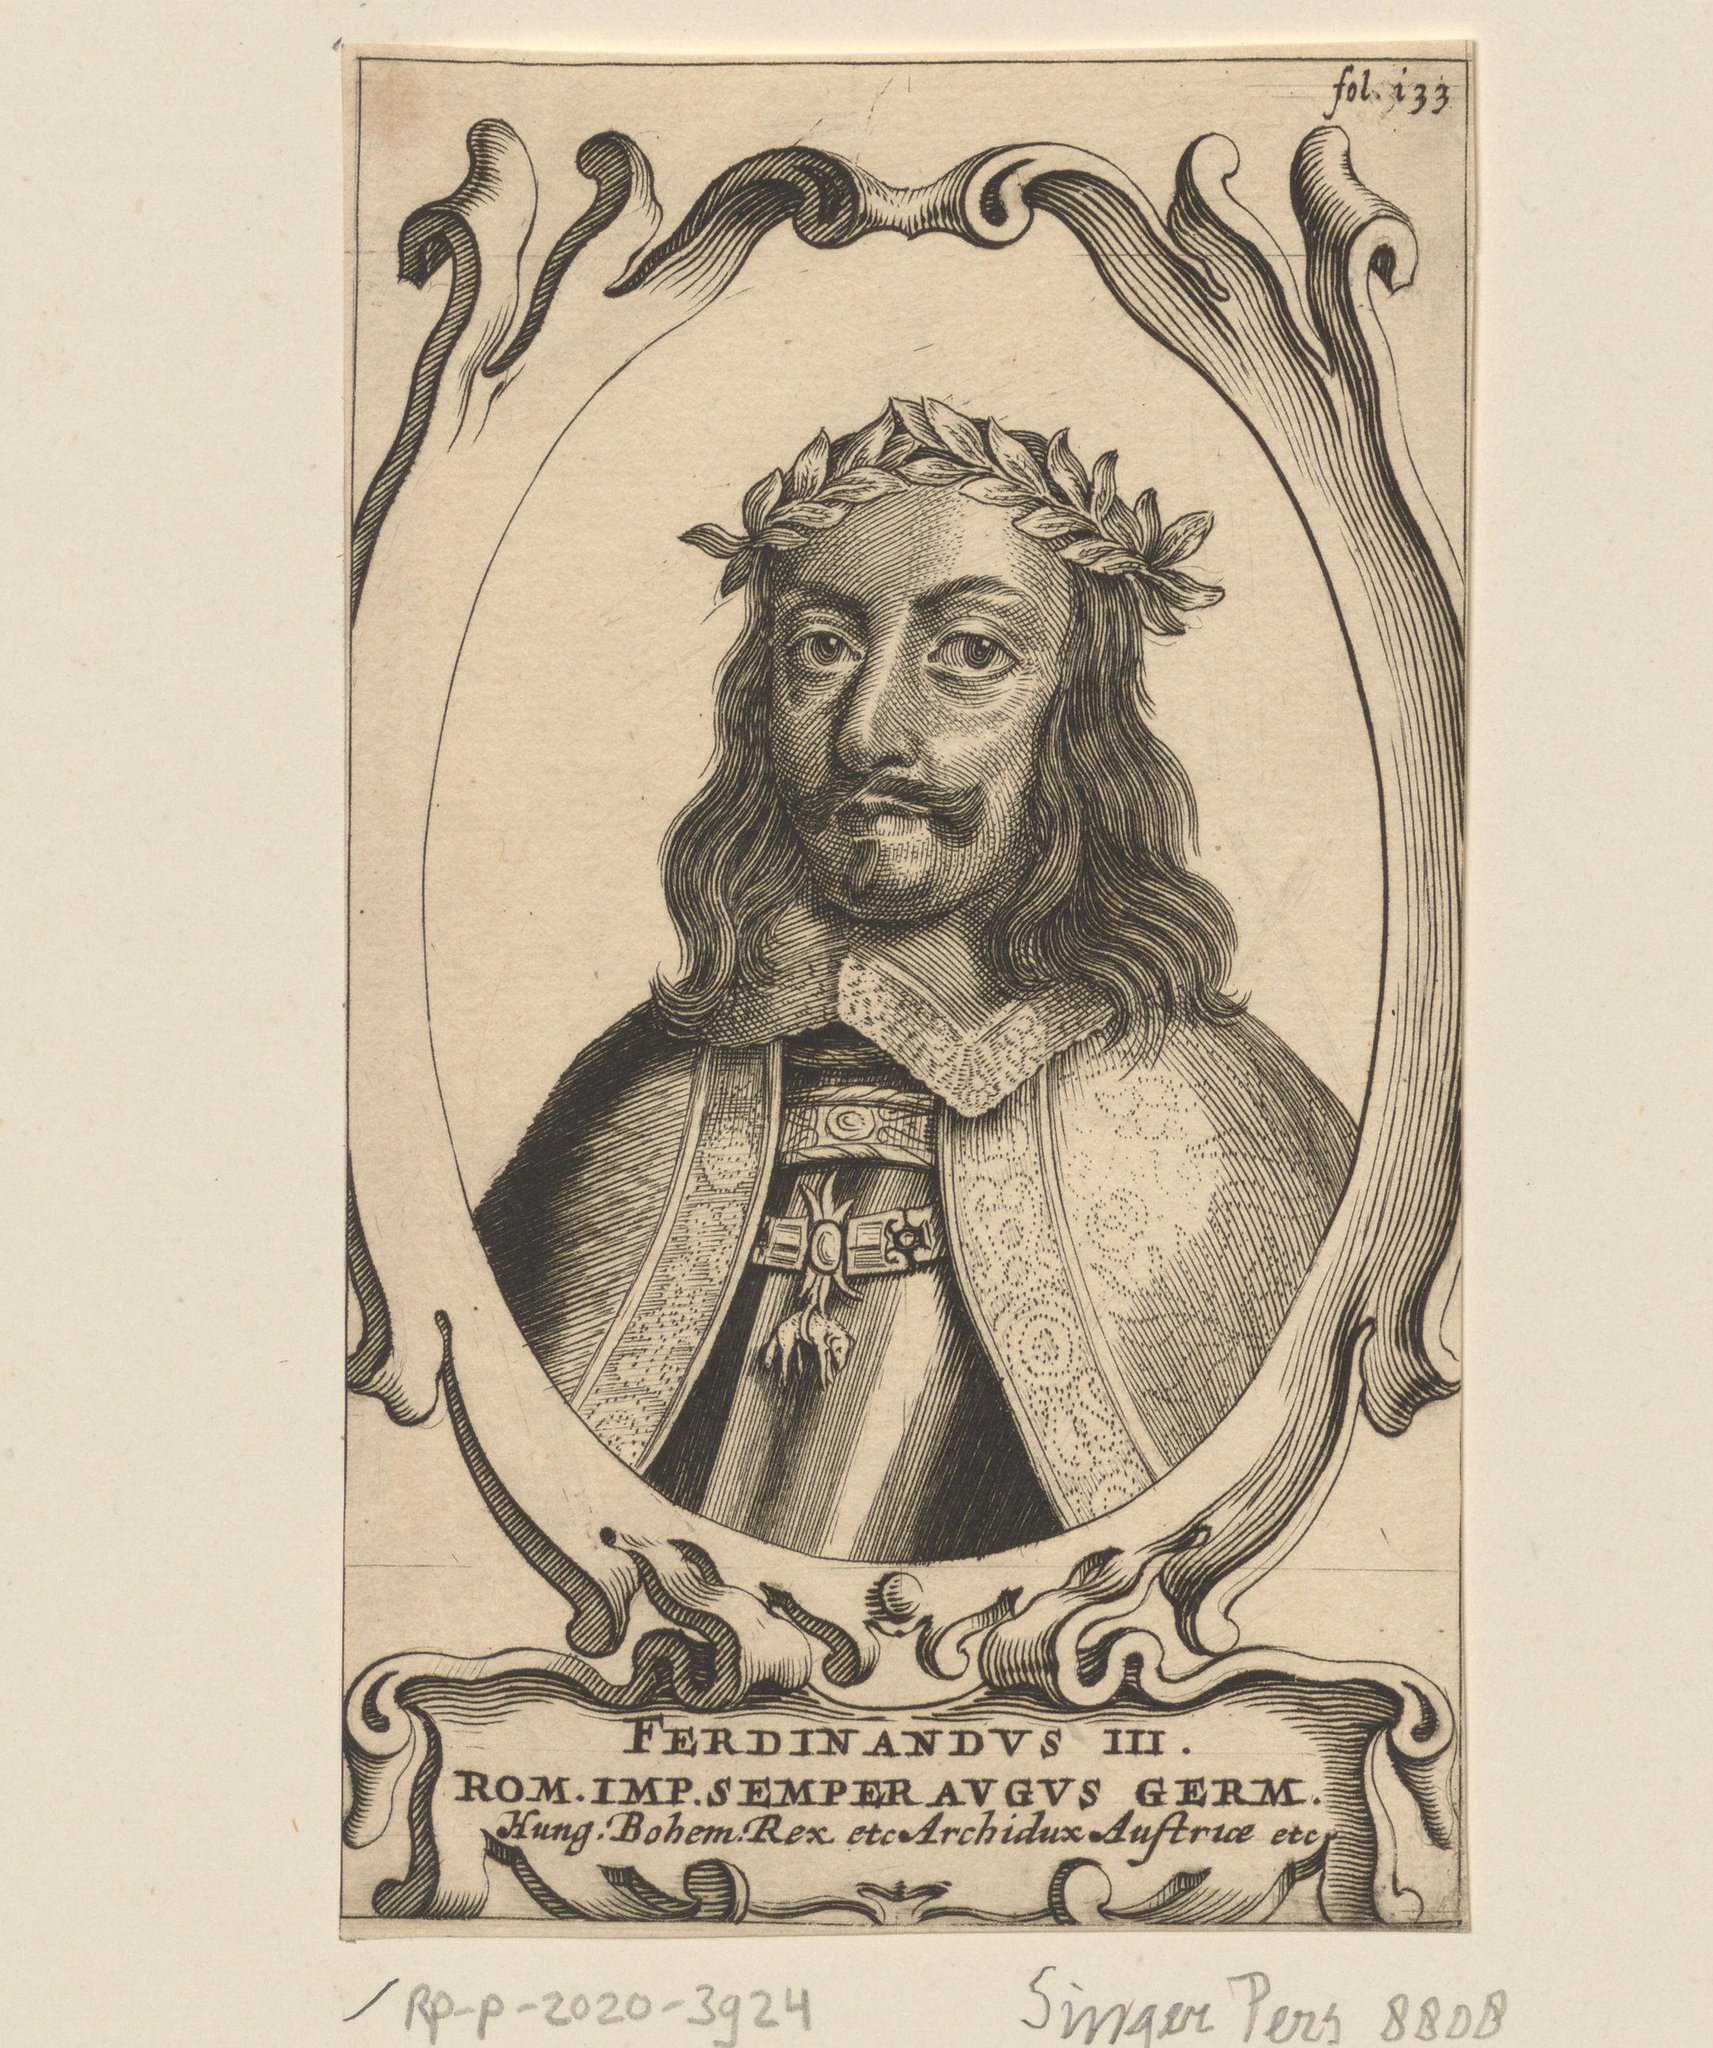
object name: book illustration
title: Portret van keizer Ferdinand III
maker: Anonymous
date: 1656-1666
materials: paper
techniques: engraving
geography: northern netherlands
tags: vienna, ferdinand iii (duits keizer), historical persons, knighthood order of the golden fleece, emperor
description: Prent waarschijnlijk uit: Brachelius, Johannes Adolphus. Historia nostri temporis, dat is geschiedenis onses tijts (…). Rotterdam: Andries van Hoogenhuysen, 1656. Prent ook gebruikt in de 1659- en 1666-editie.